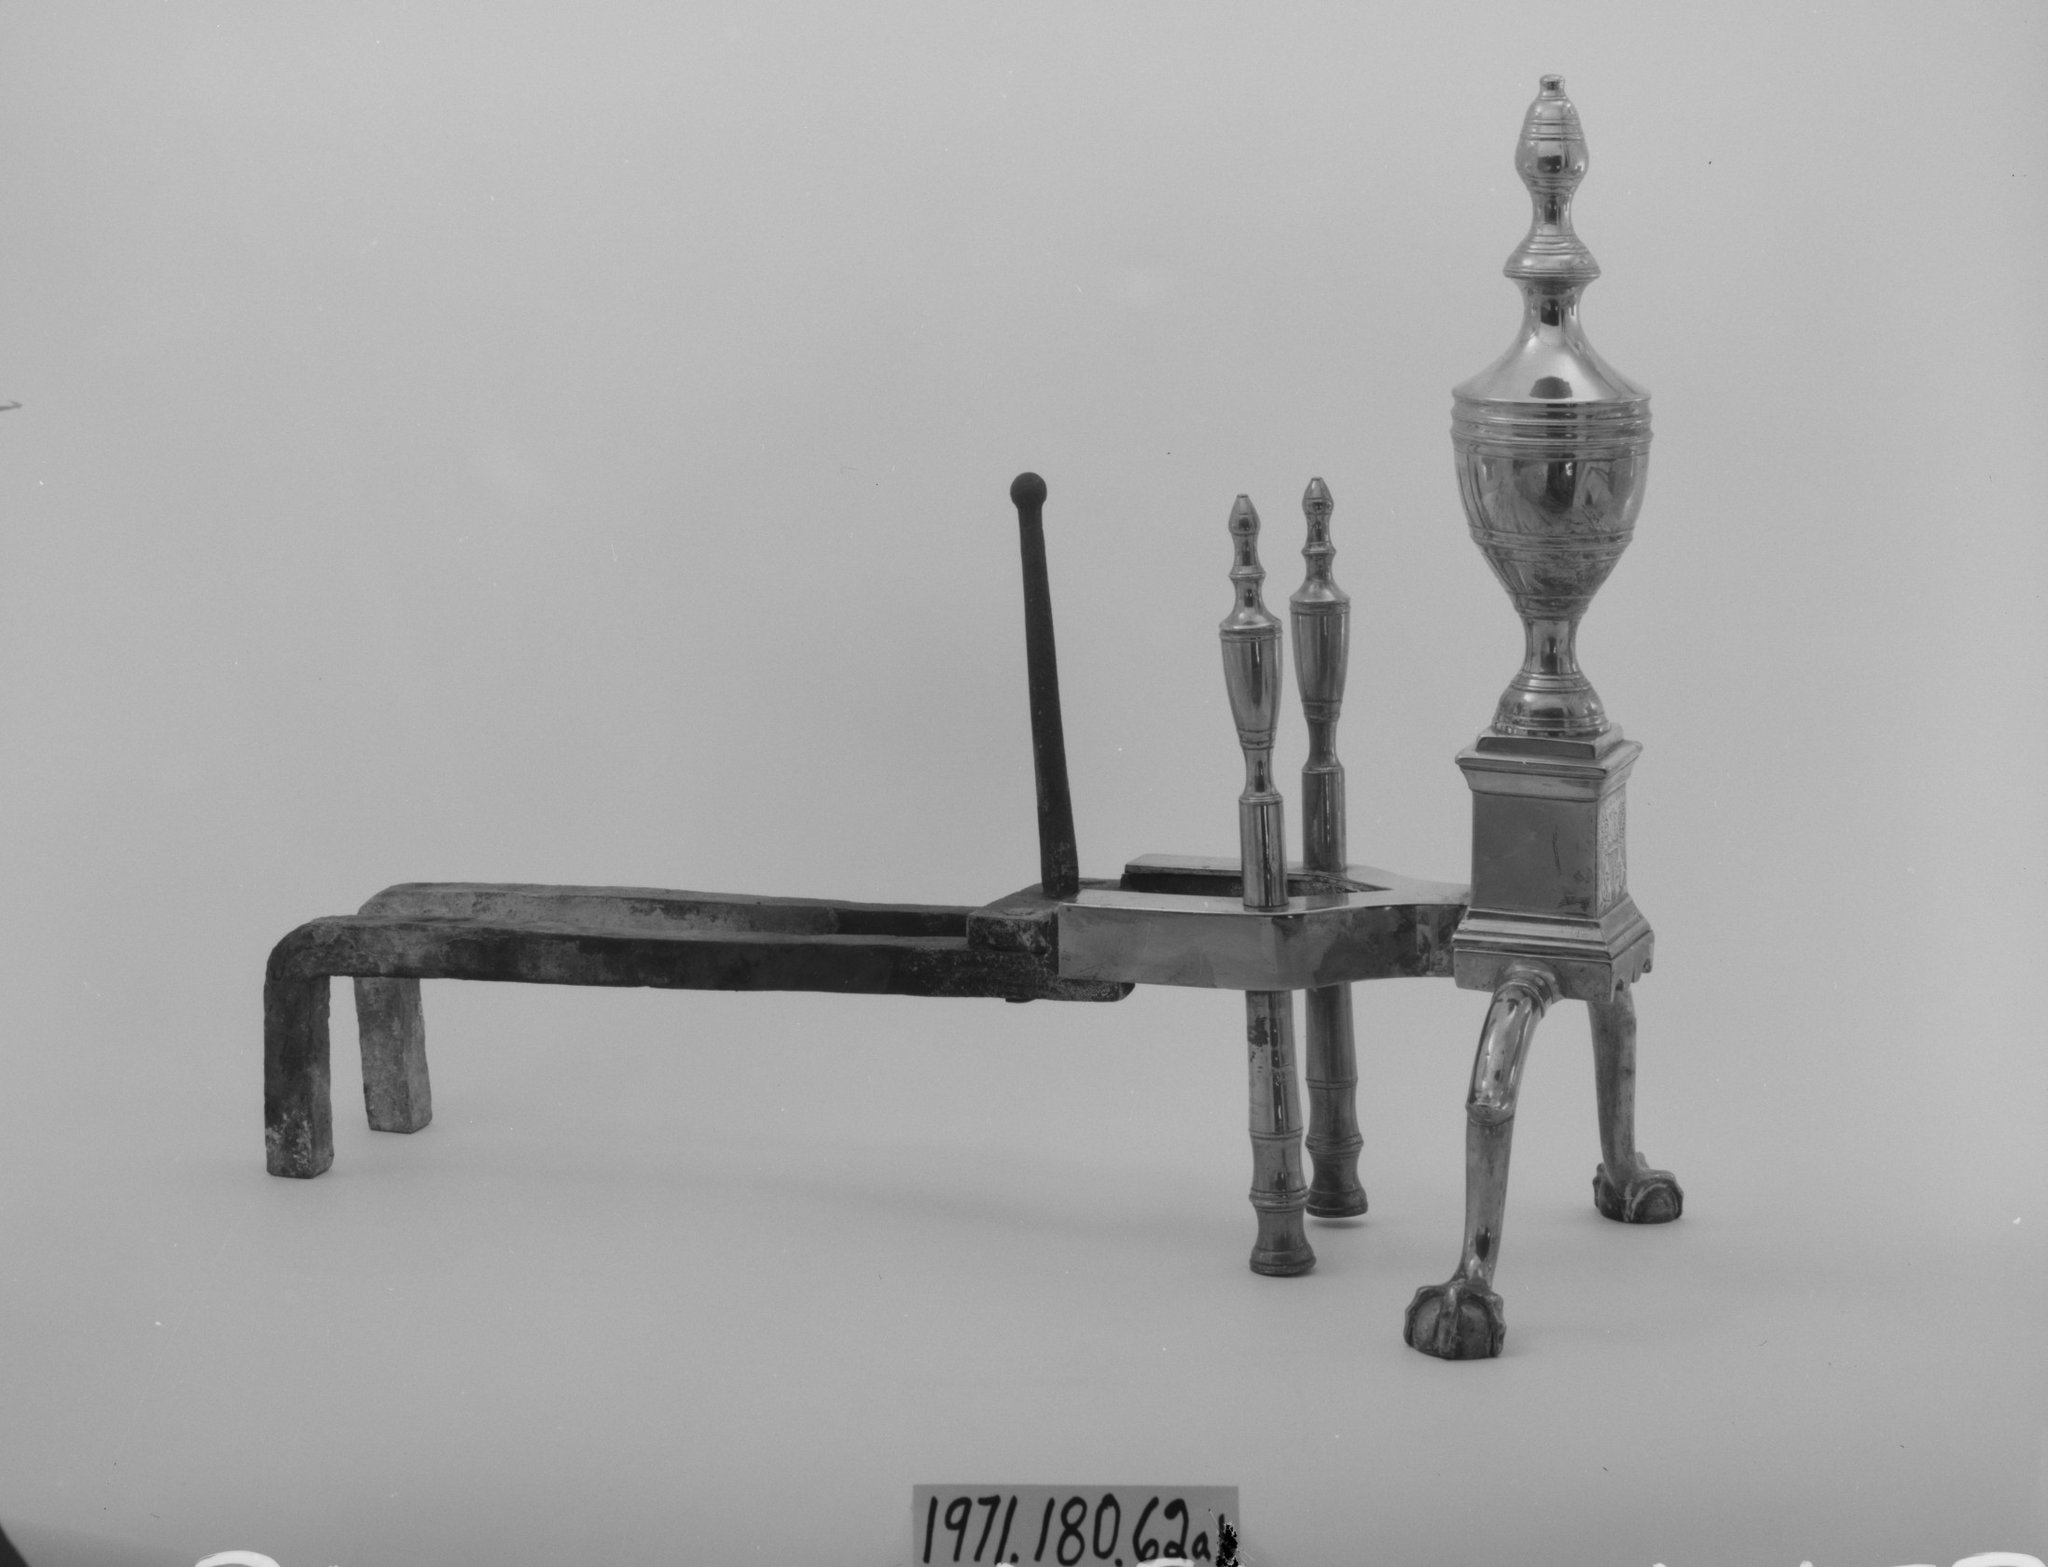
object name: andiron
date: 1790-1820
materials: brass, iron